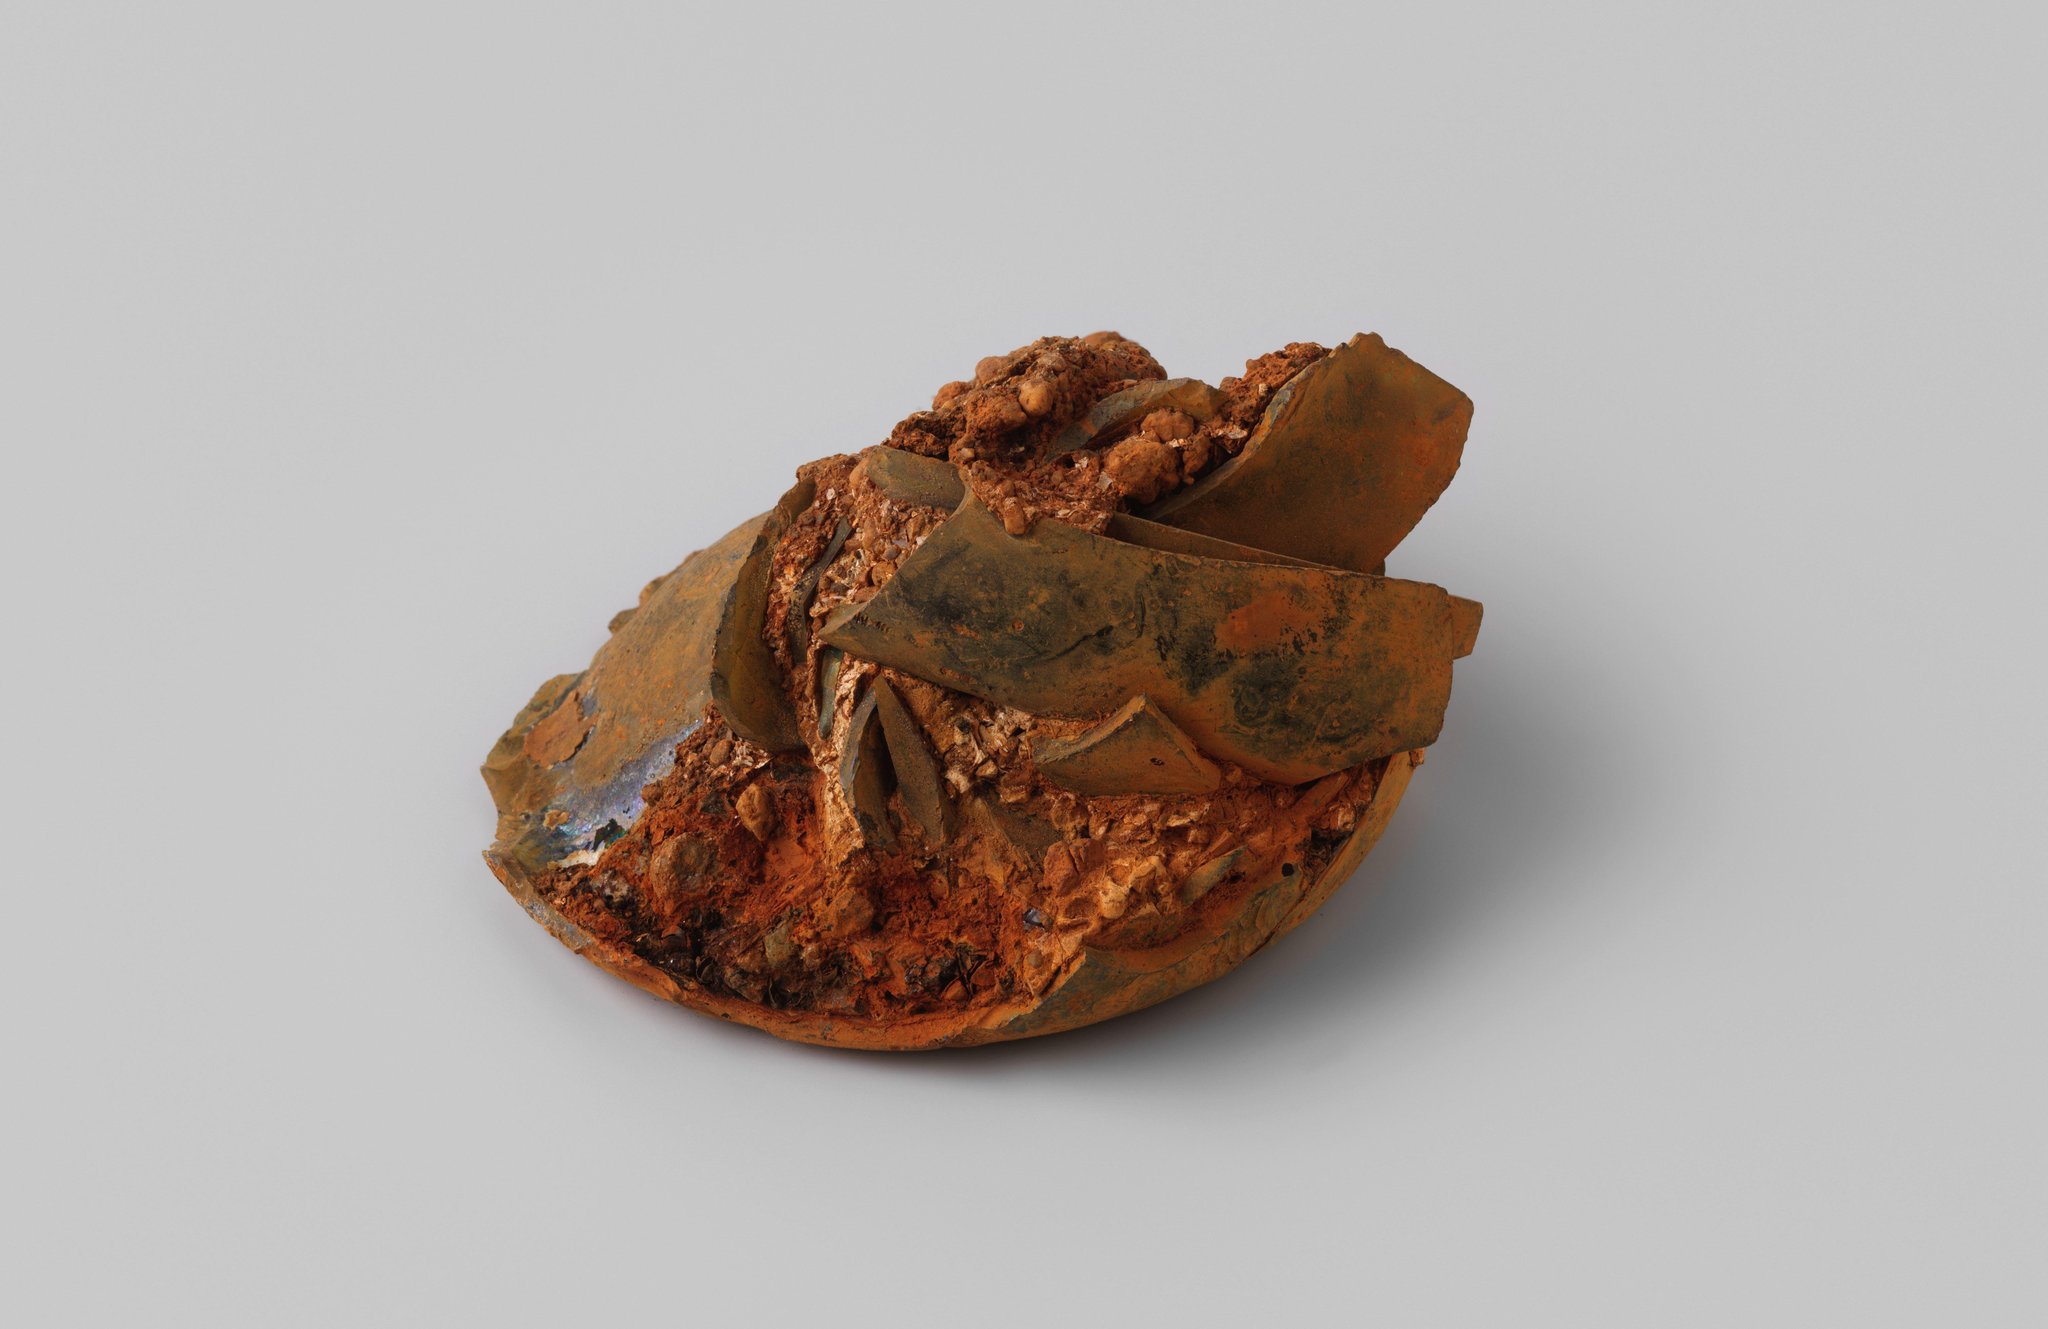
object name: sherd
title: Bodemfragment wijnfles uit het wrak van de Oost-Indiëvaarder Hollandia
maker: Anonymous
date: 1700-1743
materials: stone, glass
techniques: green glass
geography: netherlands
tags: verenigde oostindische compagnie, hollandia (schip), annet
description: Onion-shaped bottle or bottle with vertical side, base, tcs-kick-up. Continental production.